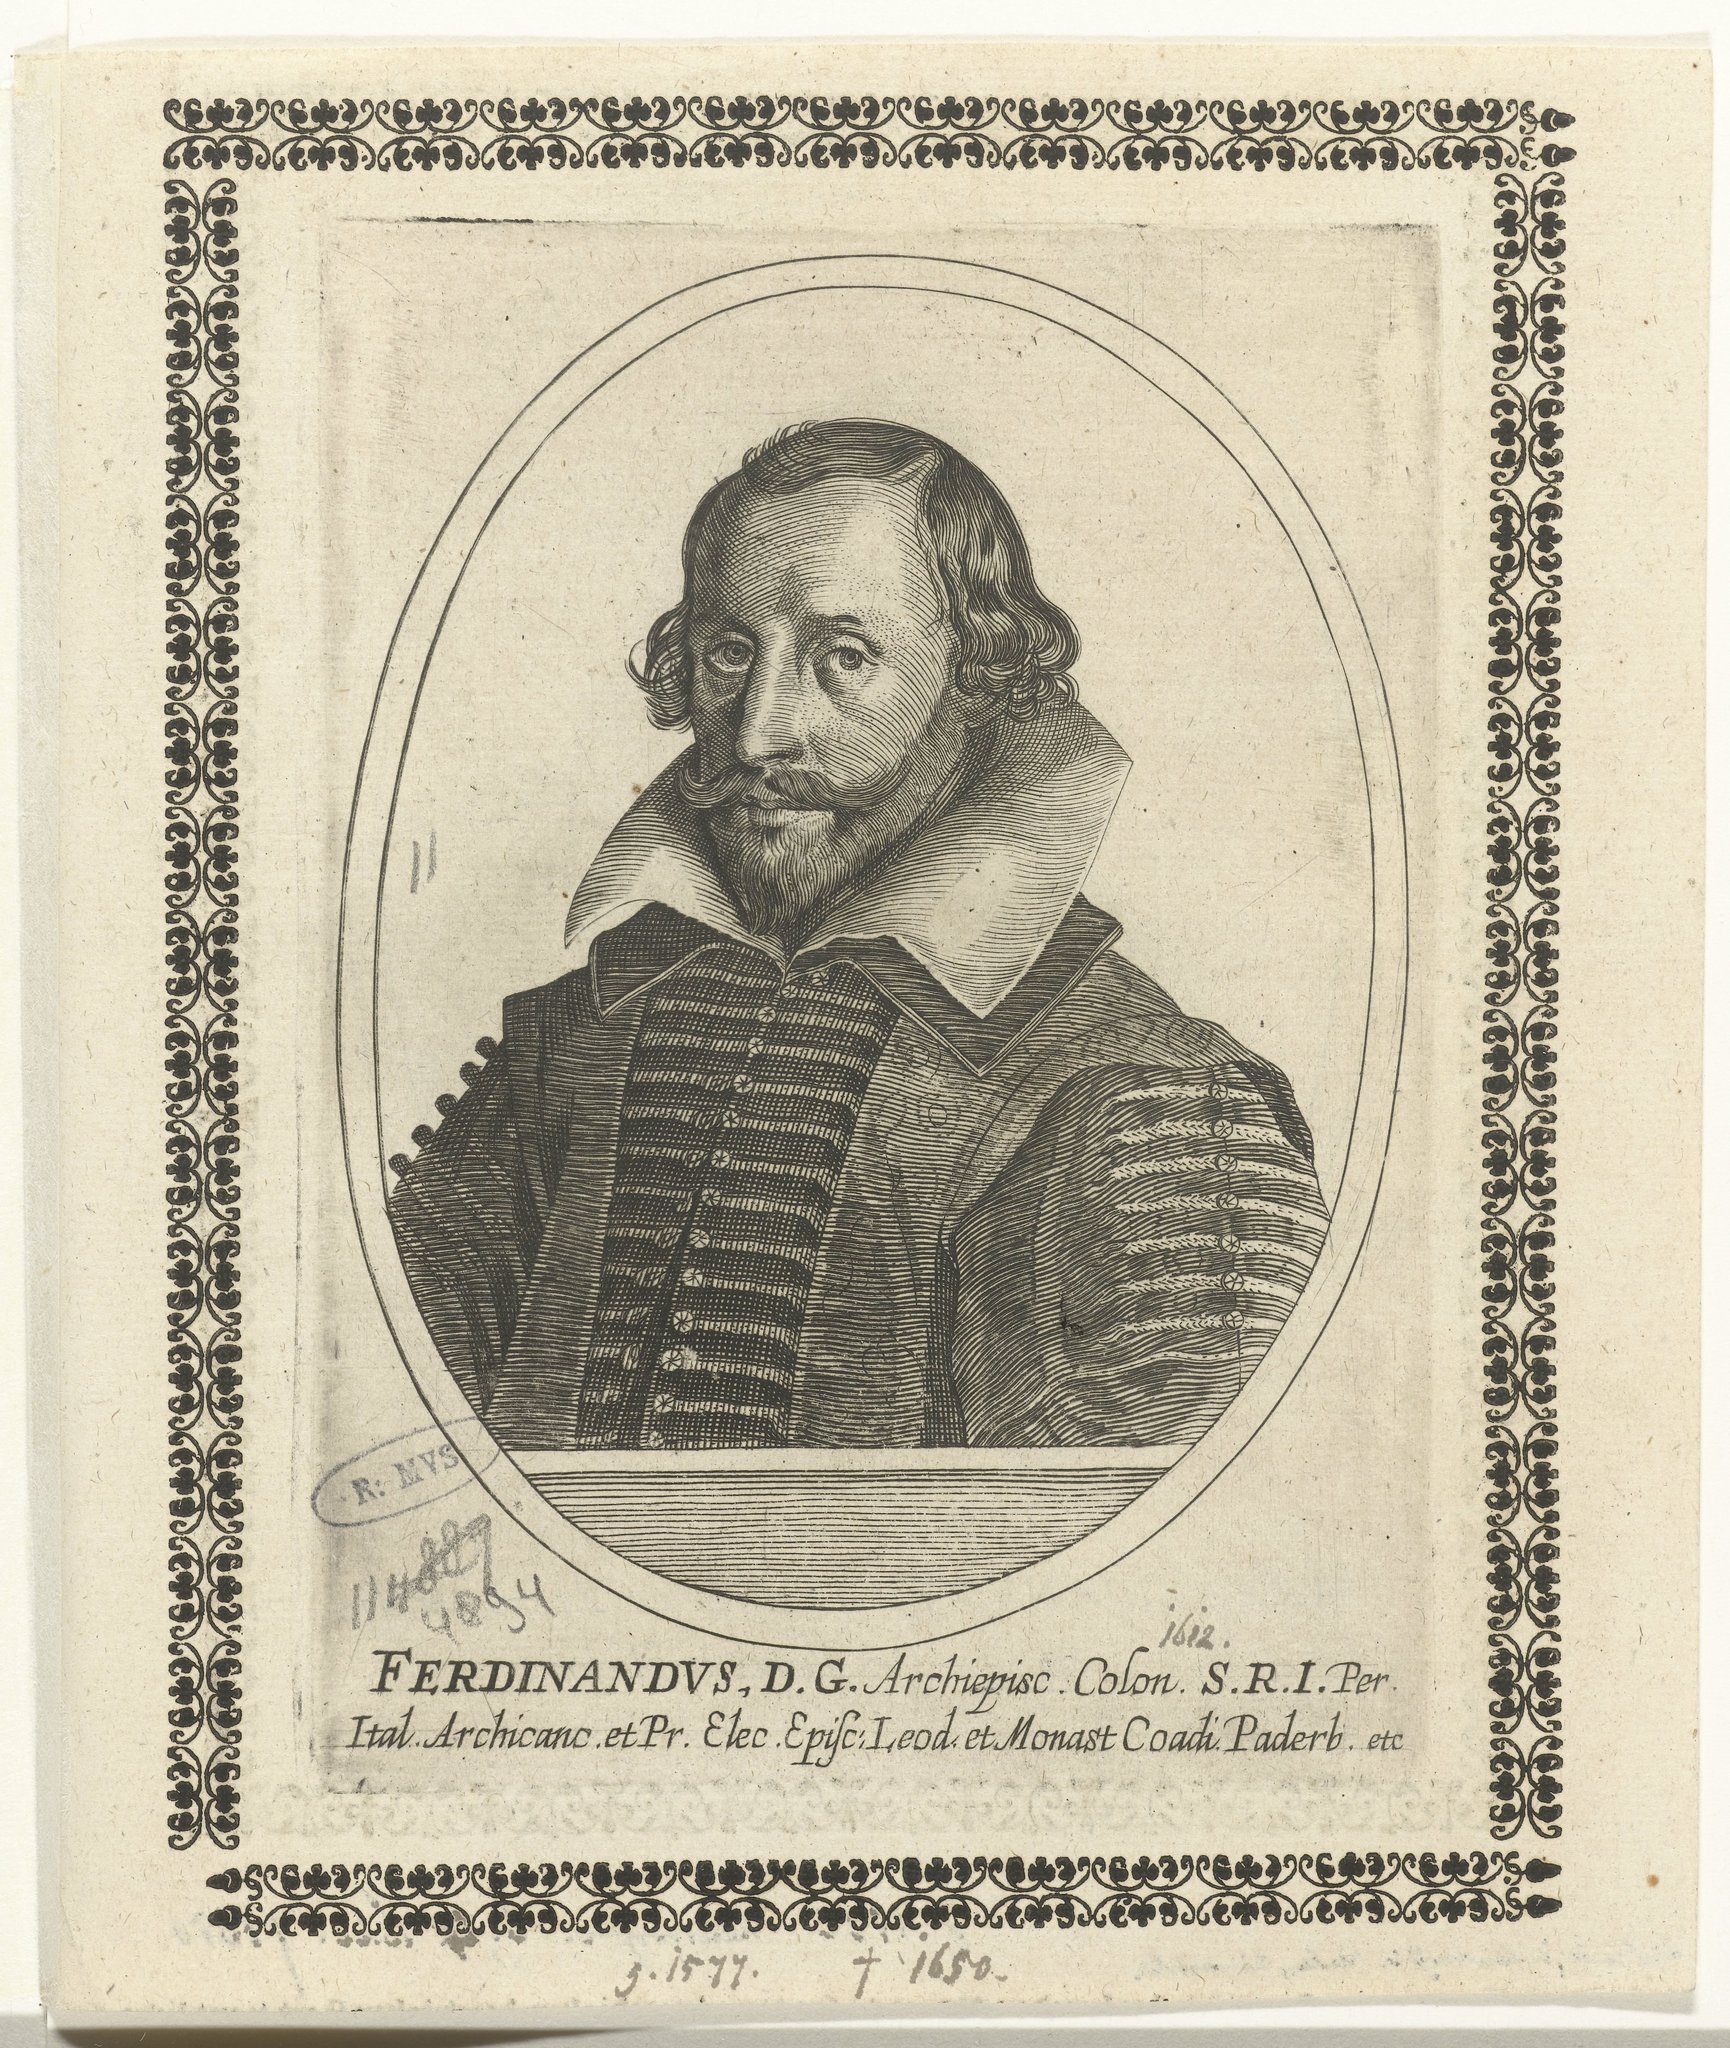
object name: book illustration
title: Ferdinandvs, D.G. Archiepisc. (...) Monast Coadi Paderborn etc.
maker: cornelis danckerts (i)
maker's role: print maker, publisher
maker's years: 1604-1656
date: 1613-1656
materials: paper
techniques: engraving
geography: netherlands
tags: ferdinand van beieren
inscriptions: collector's mark: Lugt 2228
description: Prent gebruikt als boekillustratie in onbekende uitgave, op het verso staat nog een ander portret, zie inv.nr. RP-P-1911-4894(R). Niet beschreven bij Hollstein.